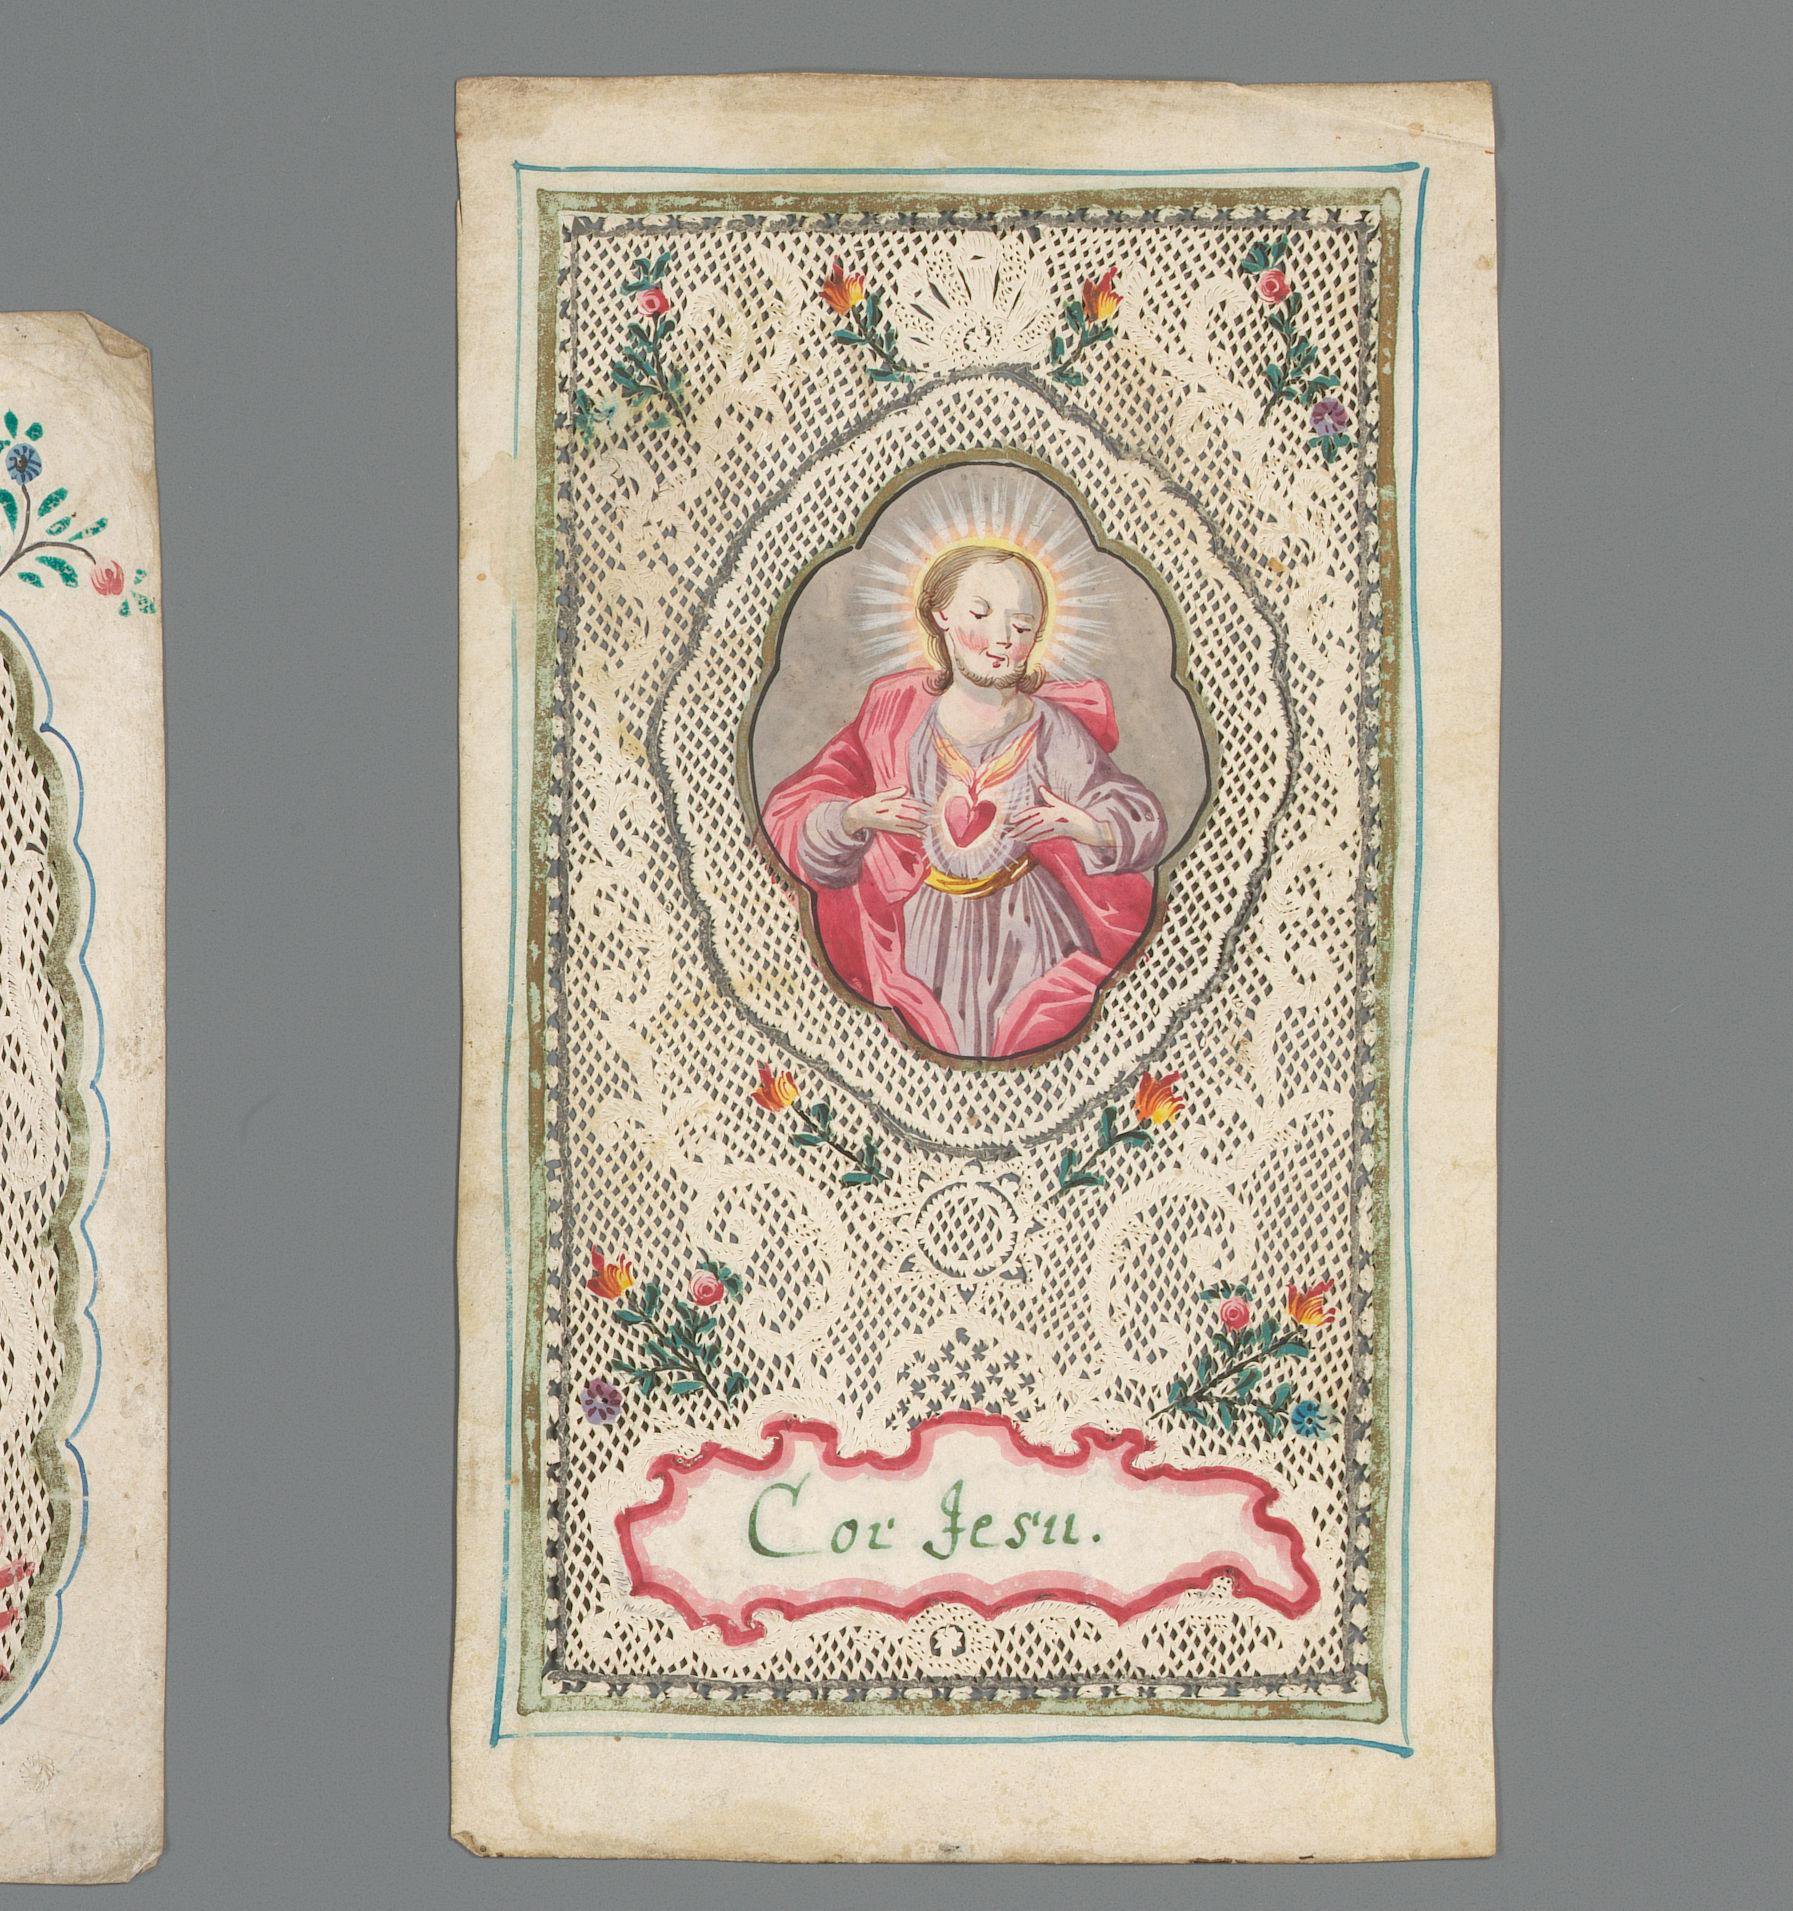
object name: cut paper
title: Cor Jesu.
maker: Anonymous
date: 1750-1784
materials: paper, watercolor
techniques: cutting, drawing, snipping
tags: the sacred heart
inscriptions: inscription: ‘Dit prenke is mij is mij gegeven van eerweerde heer Derken Lucas ottinga priester to Sneek / aen mij Agnes Maria van diemen den 9 october 1784’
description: Christus met het Heilige Hart in een uitgesneden decoratieve omlijsting met bloemen en krullen. Beneden een cartouche met de tekst: 'Cor Jesu'.